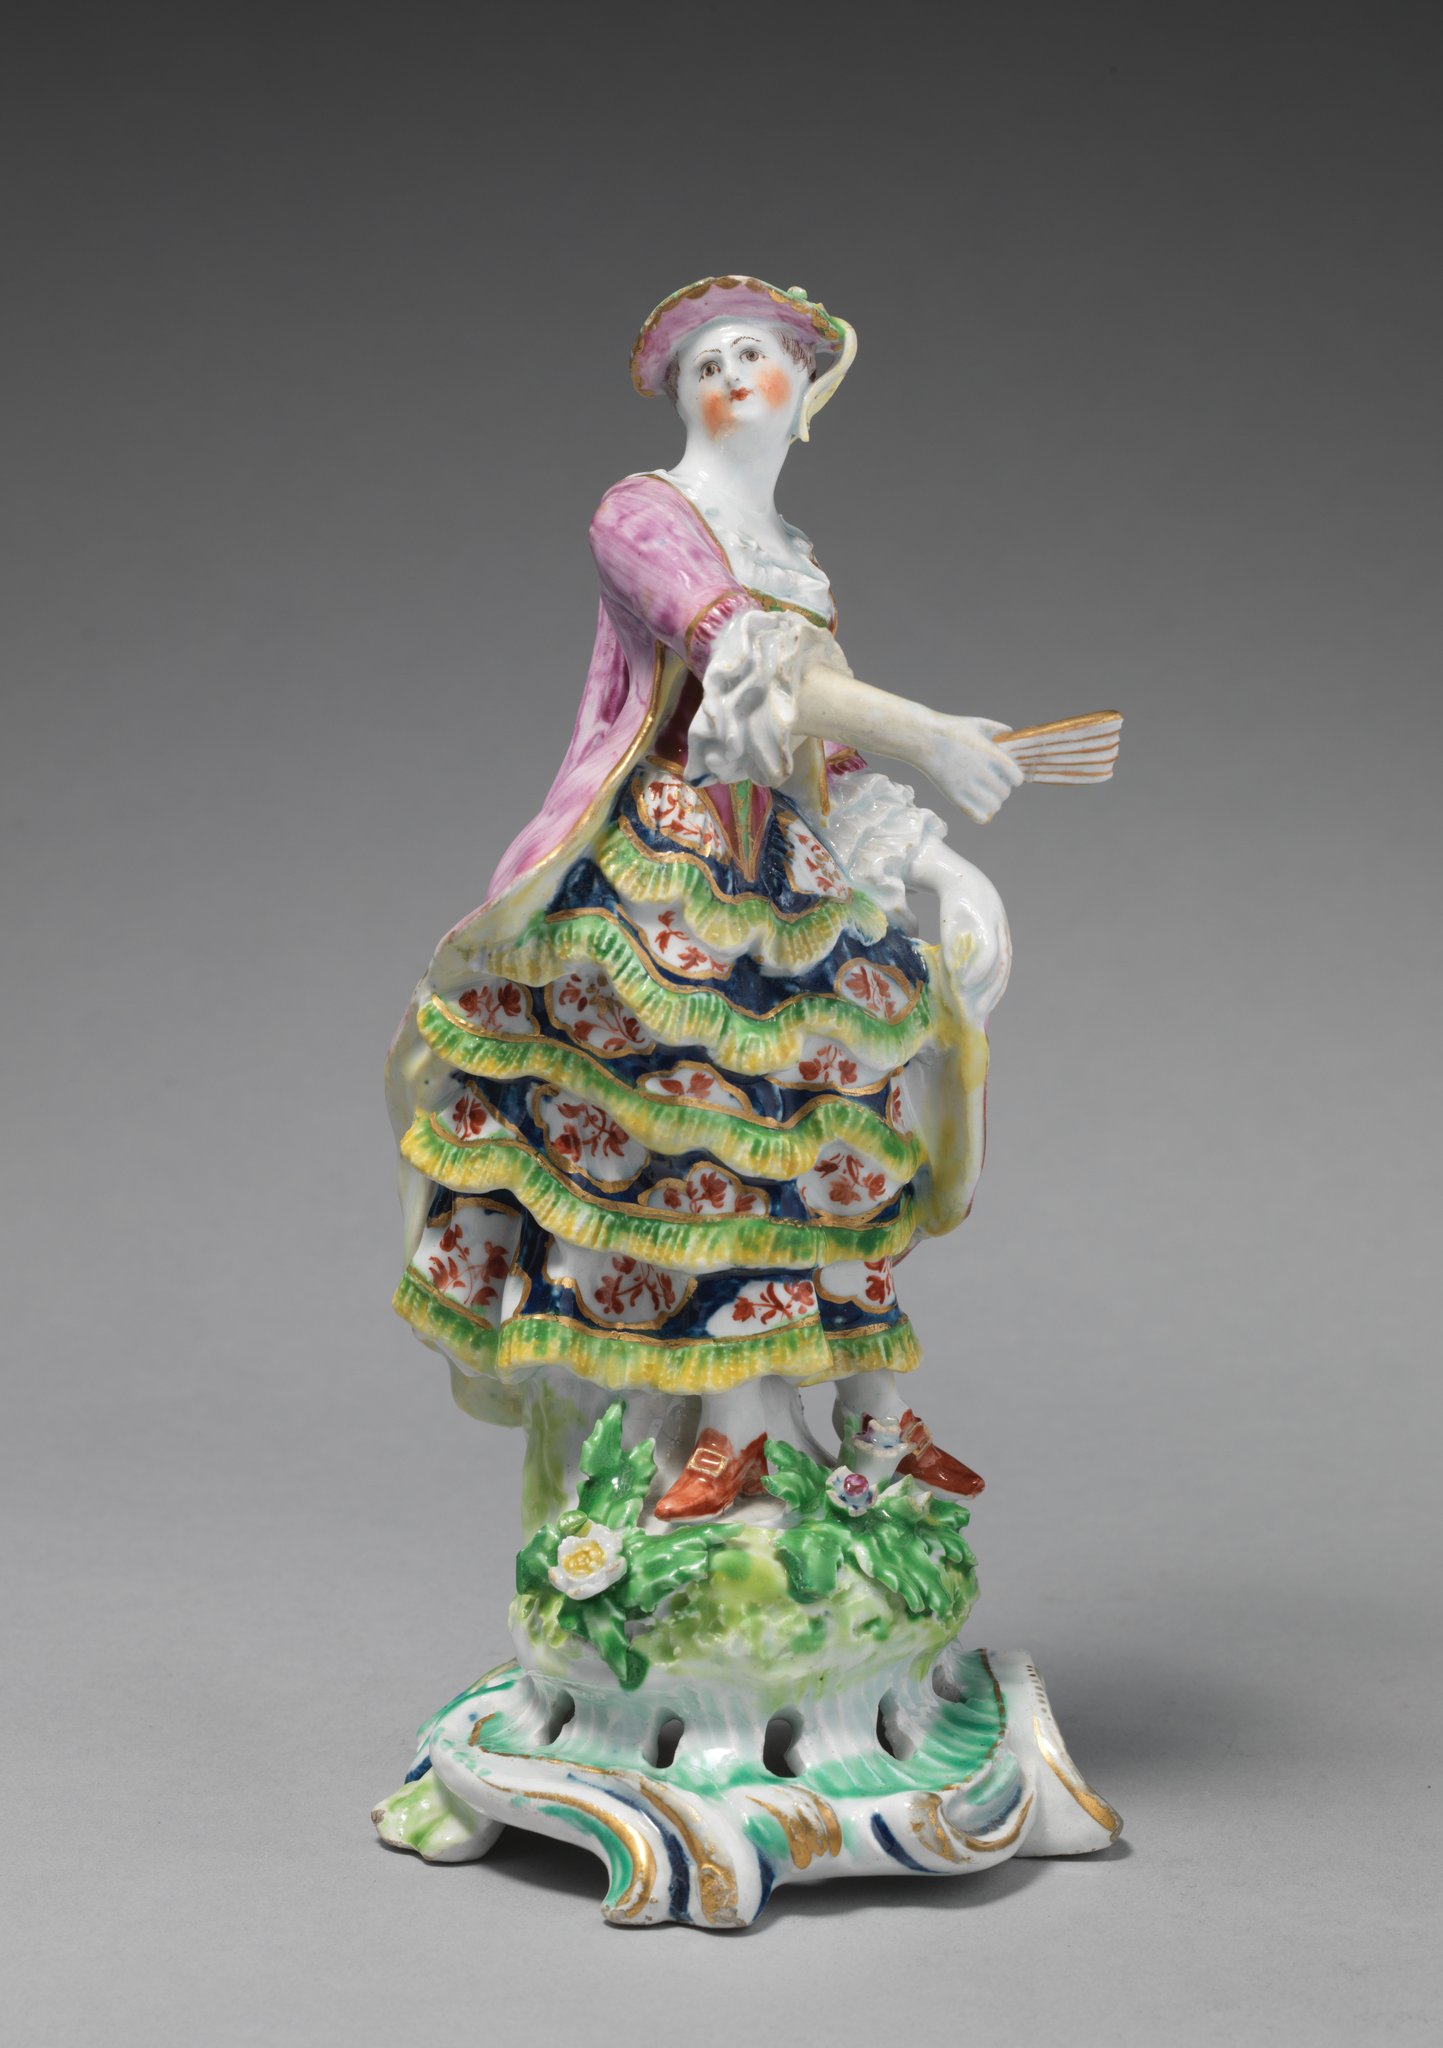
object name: figure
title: The Thrown Kiss (one of a pair)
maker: bow porcelain factory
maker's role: factory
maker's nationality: british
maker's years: 1747-1776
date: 1765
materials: soft paste porcelain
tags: women